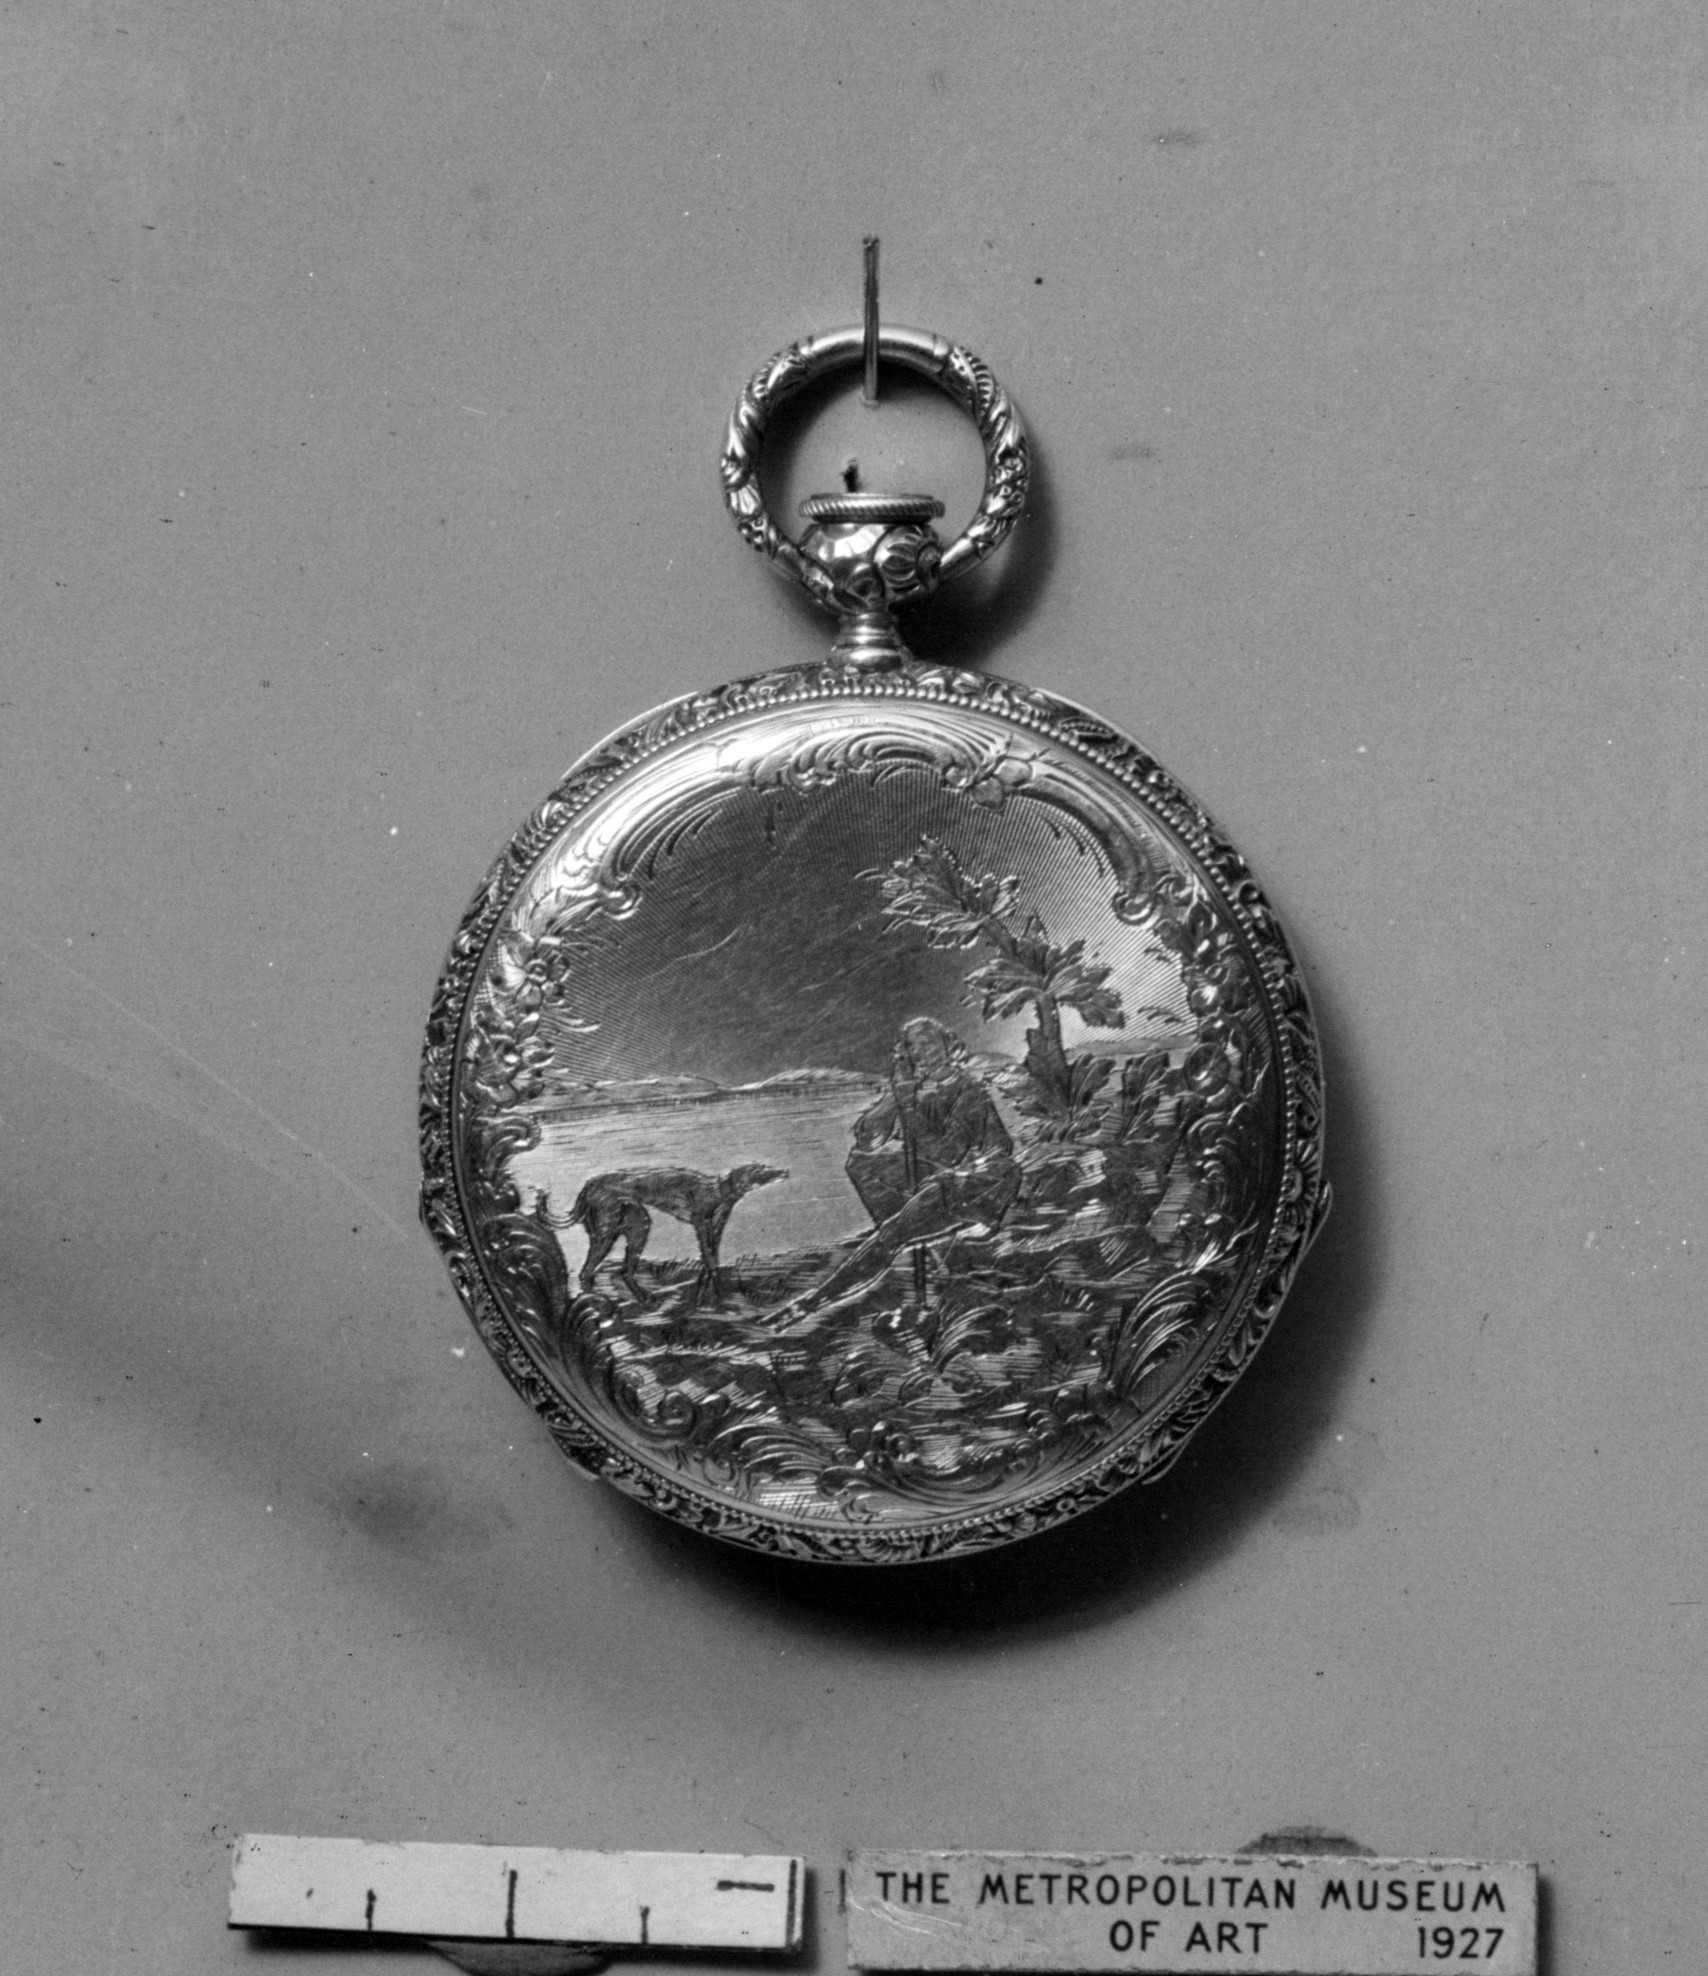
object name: watch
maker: p.a. grasseli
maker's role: maker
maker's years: 1775-1875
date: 1835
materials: enamel, gold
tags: animals,trees